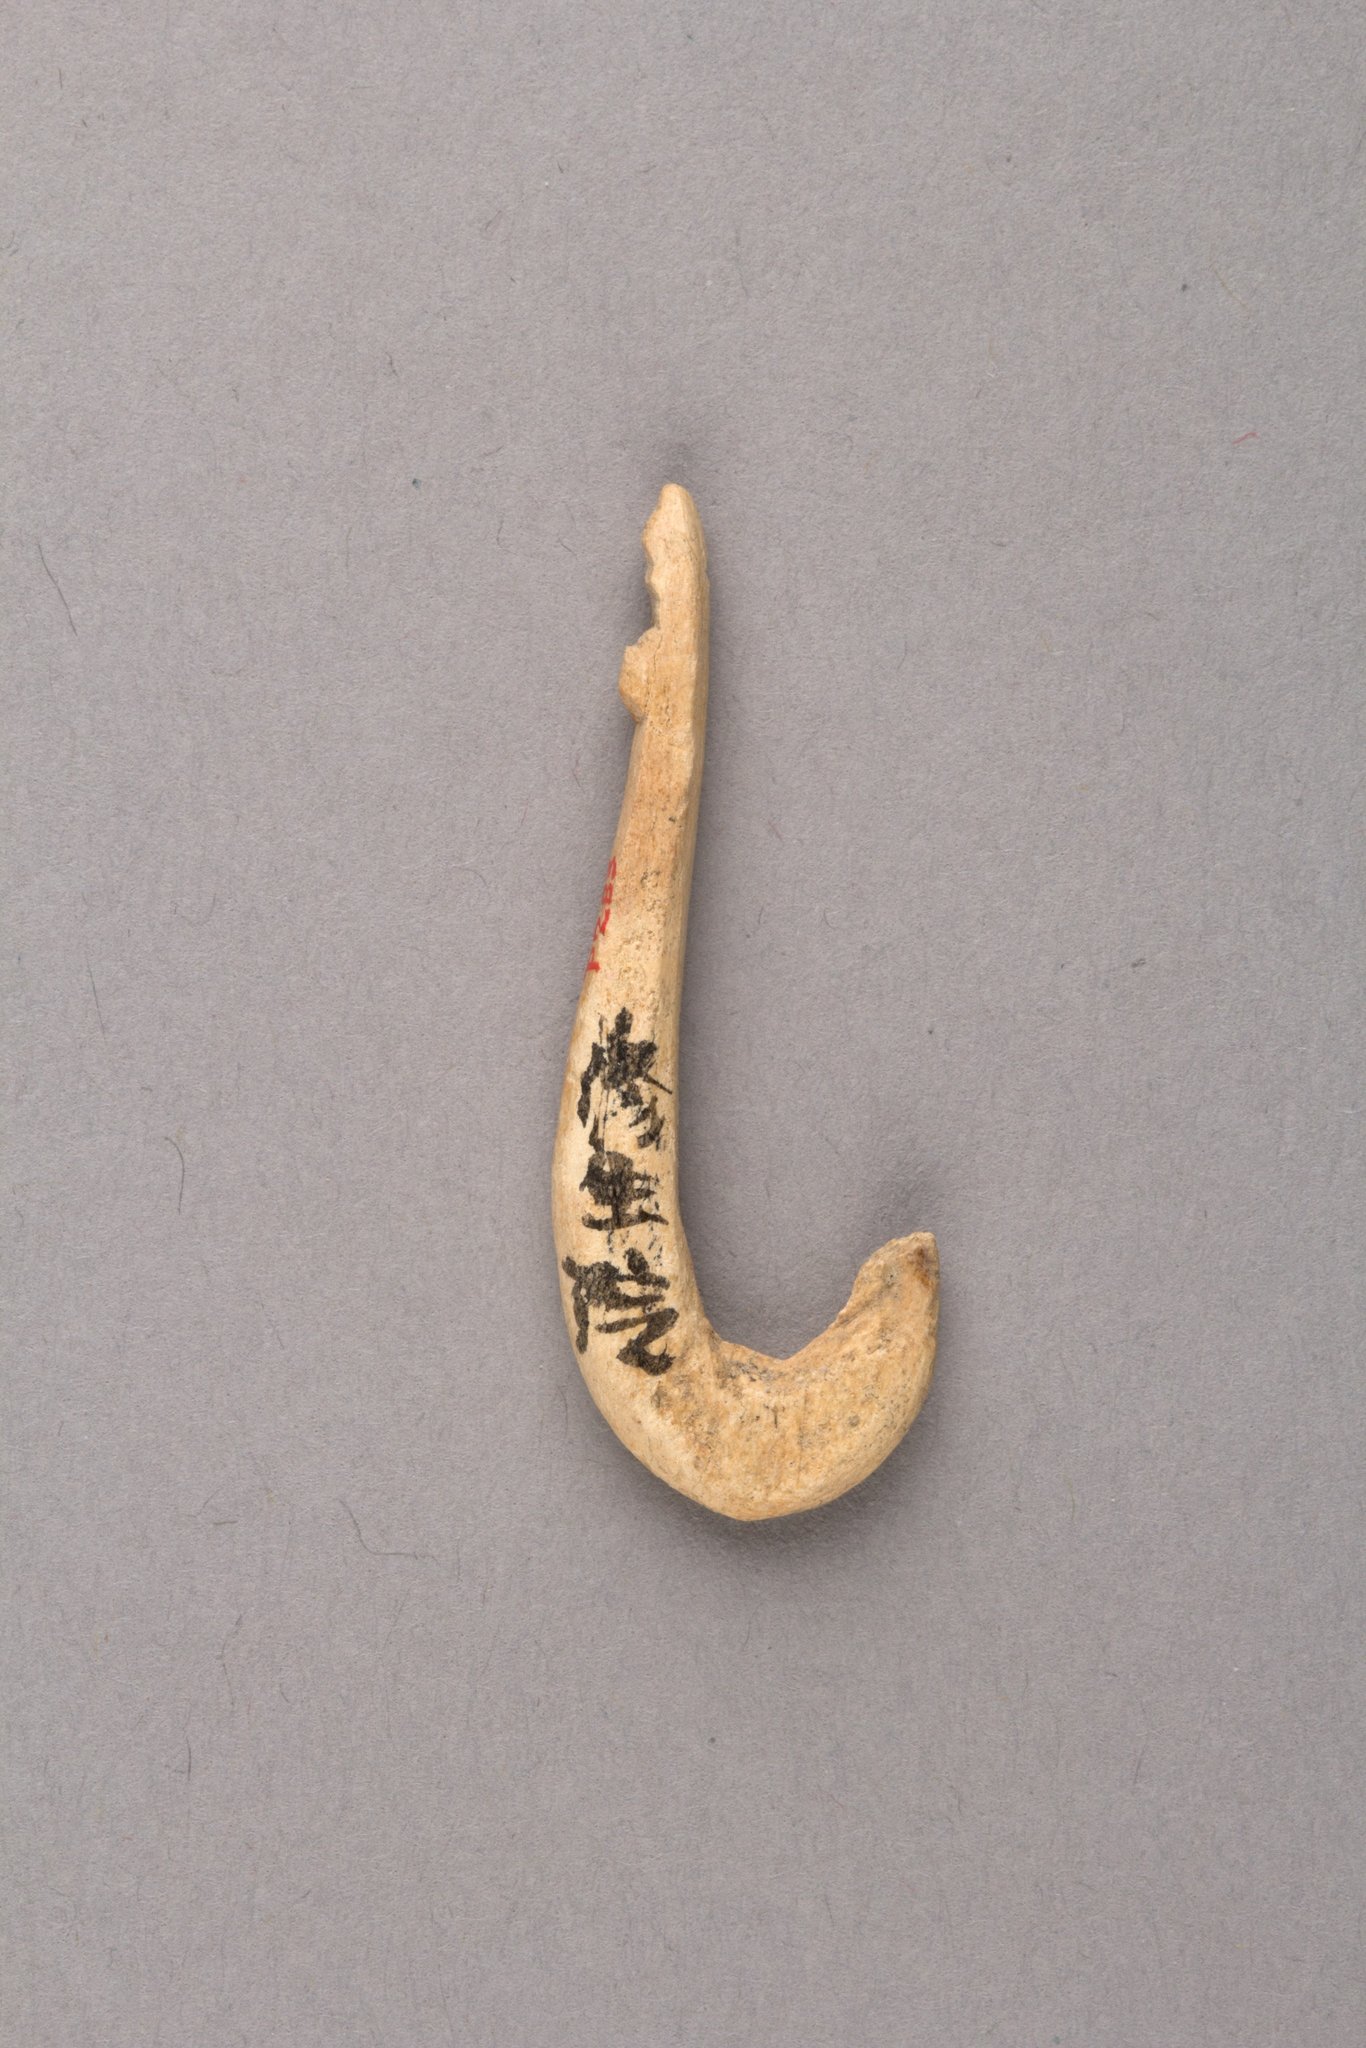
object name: fish hook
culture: japanese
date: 1000-300 BCE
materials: bone